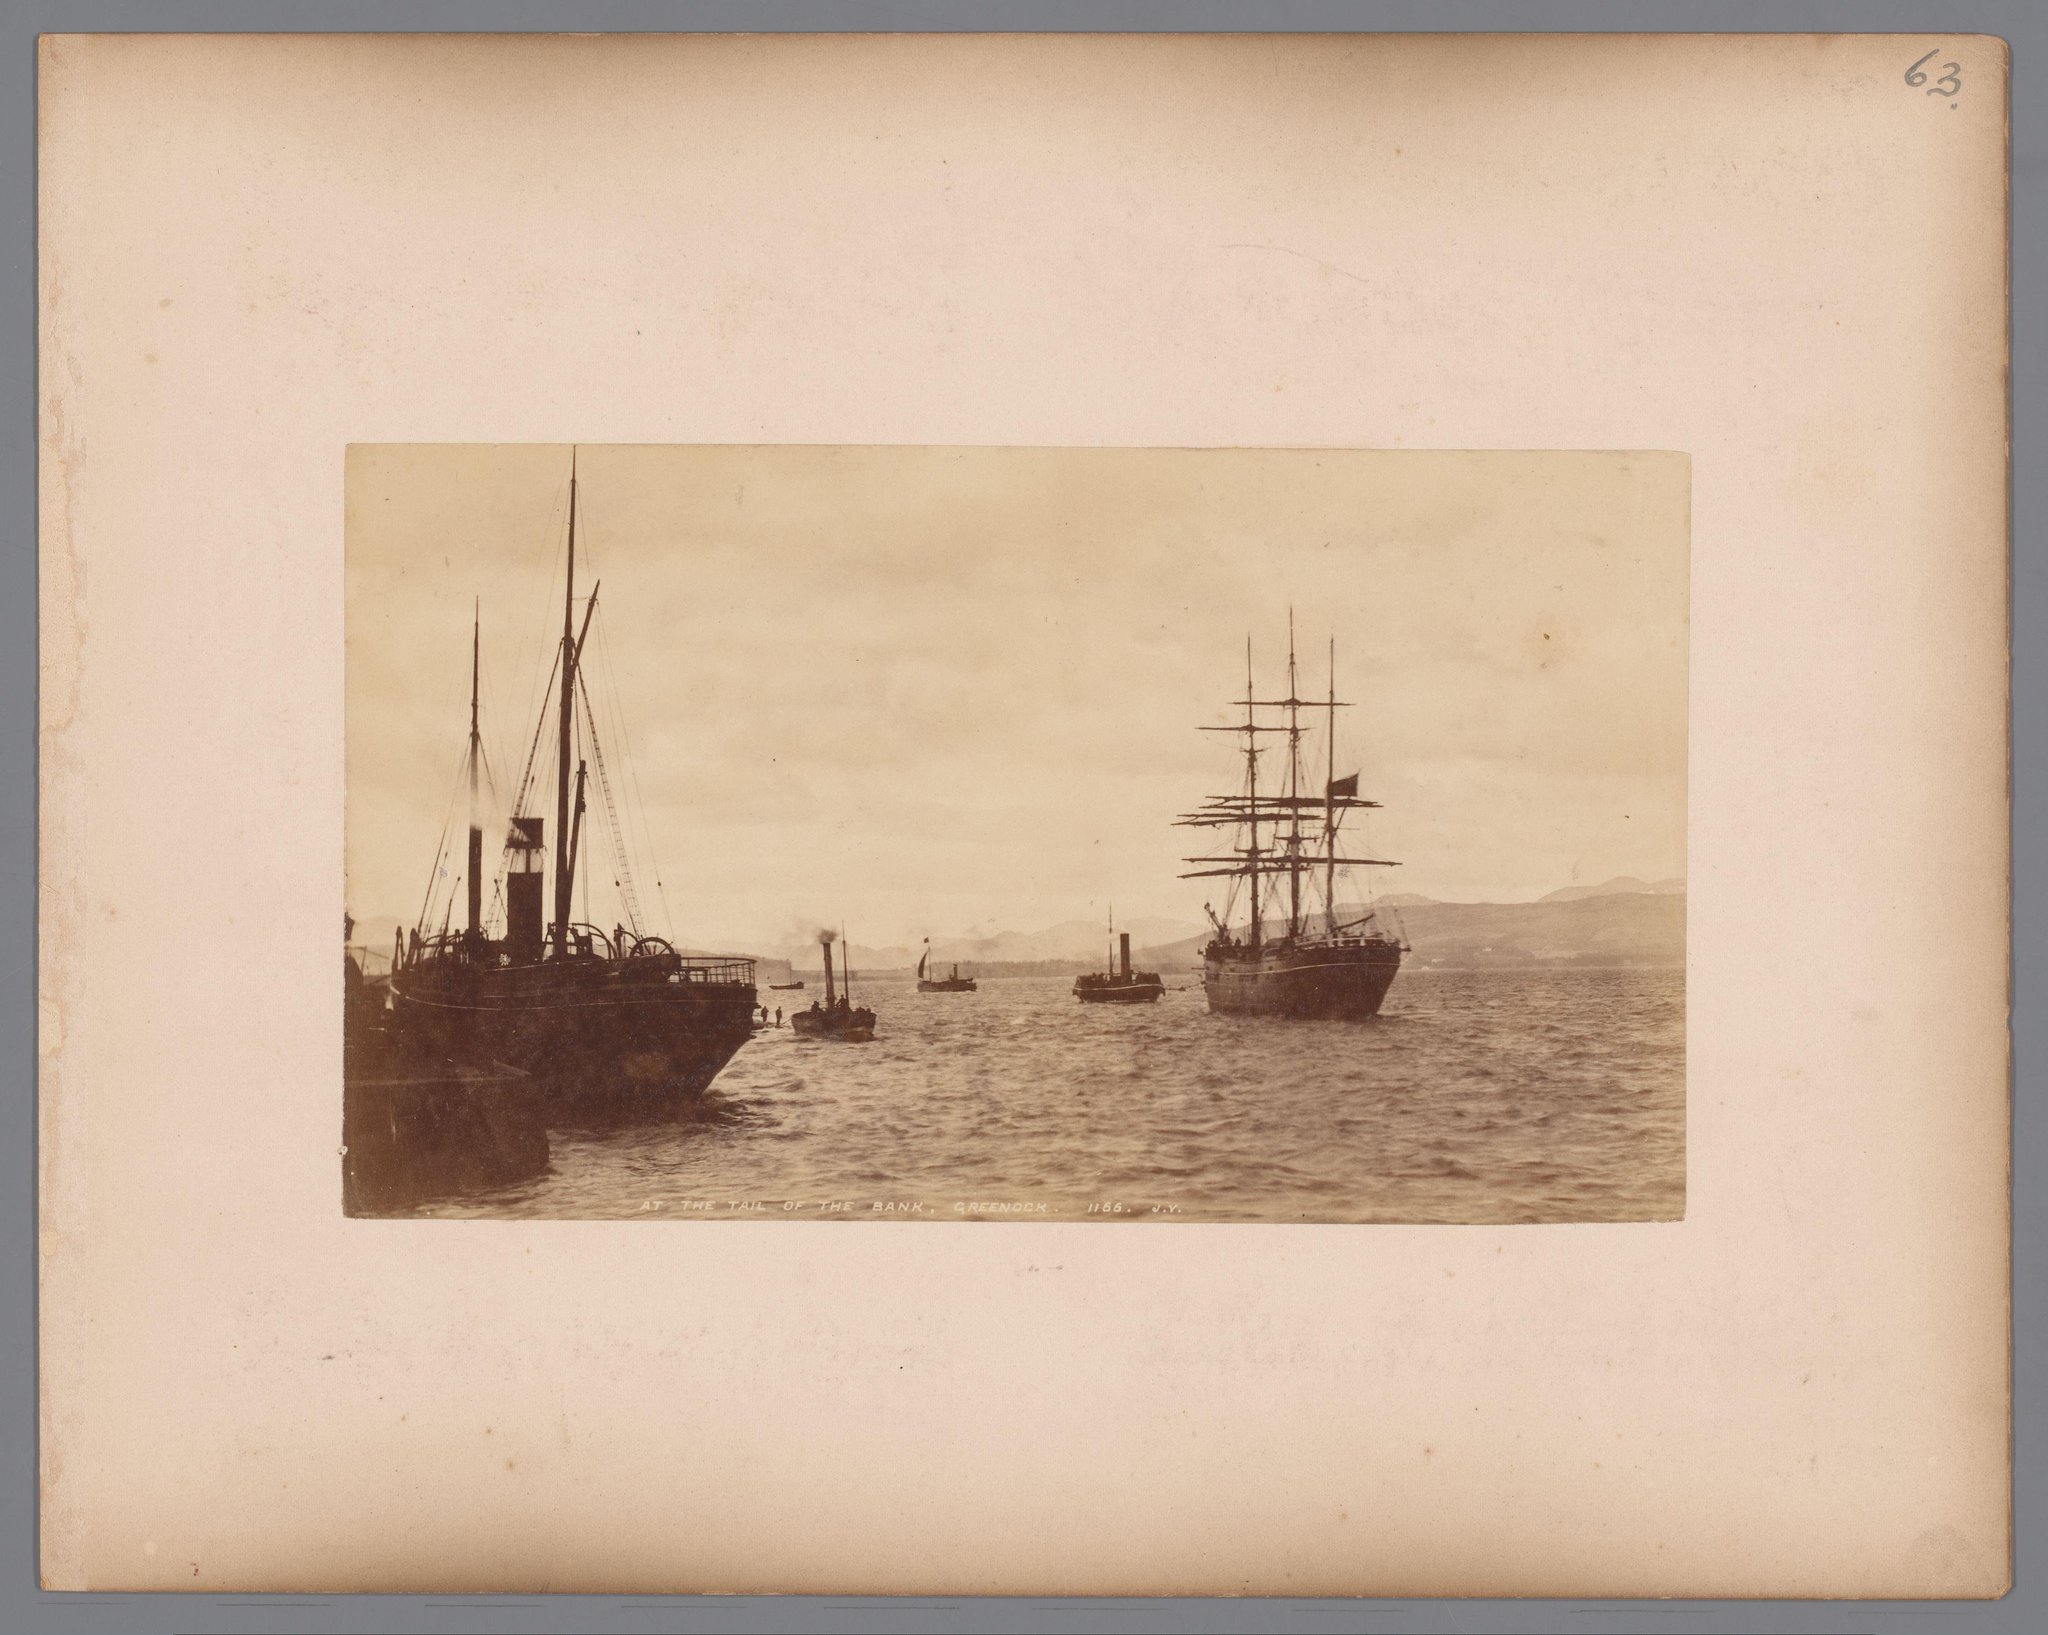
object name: photograph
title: Zeegezicht met schepen ("At the tail of the bank, Greenock")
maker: james valentine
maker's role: fotograaf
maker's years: 1815-1880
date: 1865-1890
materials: cardboard, paper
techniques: albumen print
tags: greenock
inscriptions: number: ‘64.’, number: ‘63.’, inscription: ‘AT THE TAIL OF THE BANK. 1166. J.V.’